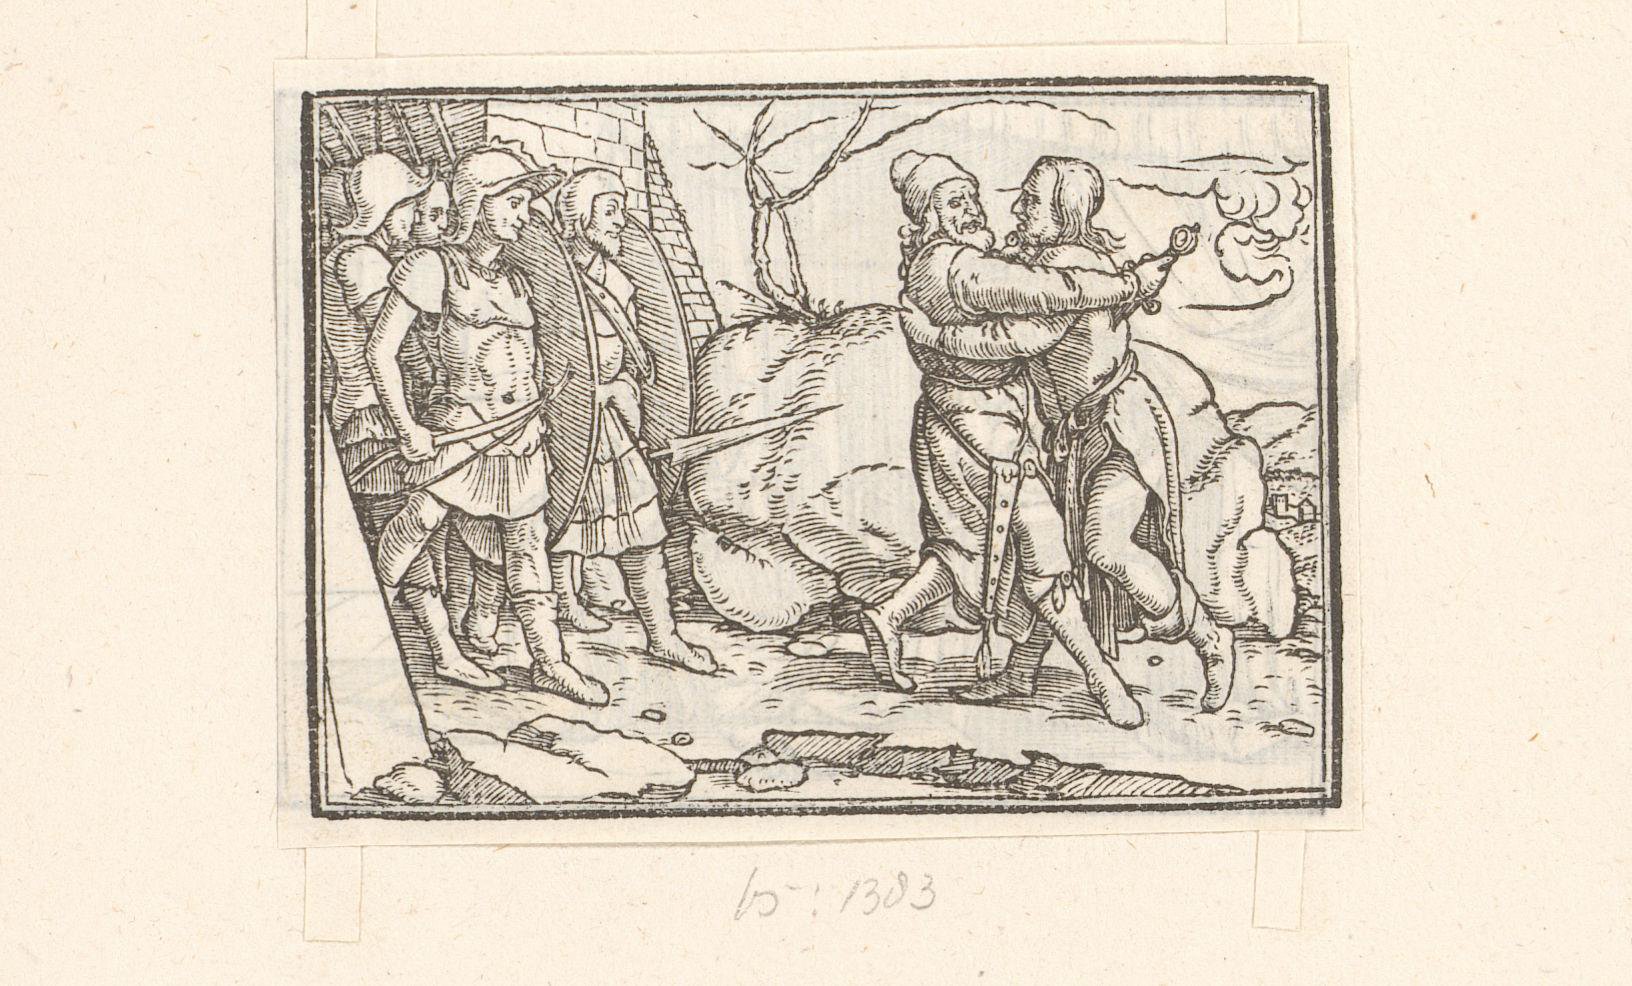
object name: album leaf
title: Joab doodt Amasa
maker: veit rudolf specklin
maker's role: print maker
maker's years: -1550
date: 1538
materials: paper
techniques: woodcut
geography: switzerland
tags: joab kills amasa: joab takes amasa by the beard with the right hand as if to kiss him, and stabs him with a dagger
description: Boekillustratie voor het eerst gebruikt in: Biblia Utriusque Testamenti iuxta Vulgatam Translationem, Lyon, M. en G. Trechsel (voor Hugo à Porta) 1538. Later in verschillende uitgaven opnieuw gebruikt. Deze prent vermoedelijk gebruikt in één van de uitgaven uitgegeven en/of gedrukt door Jean Frellon, Lyon.